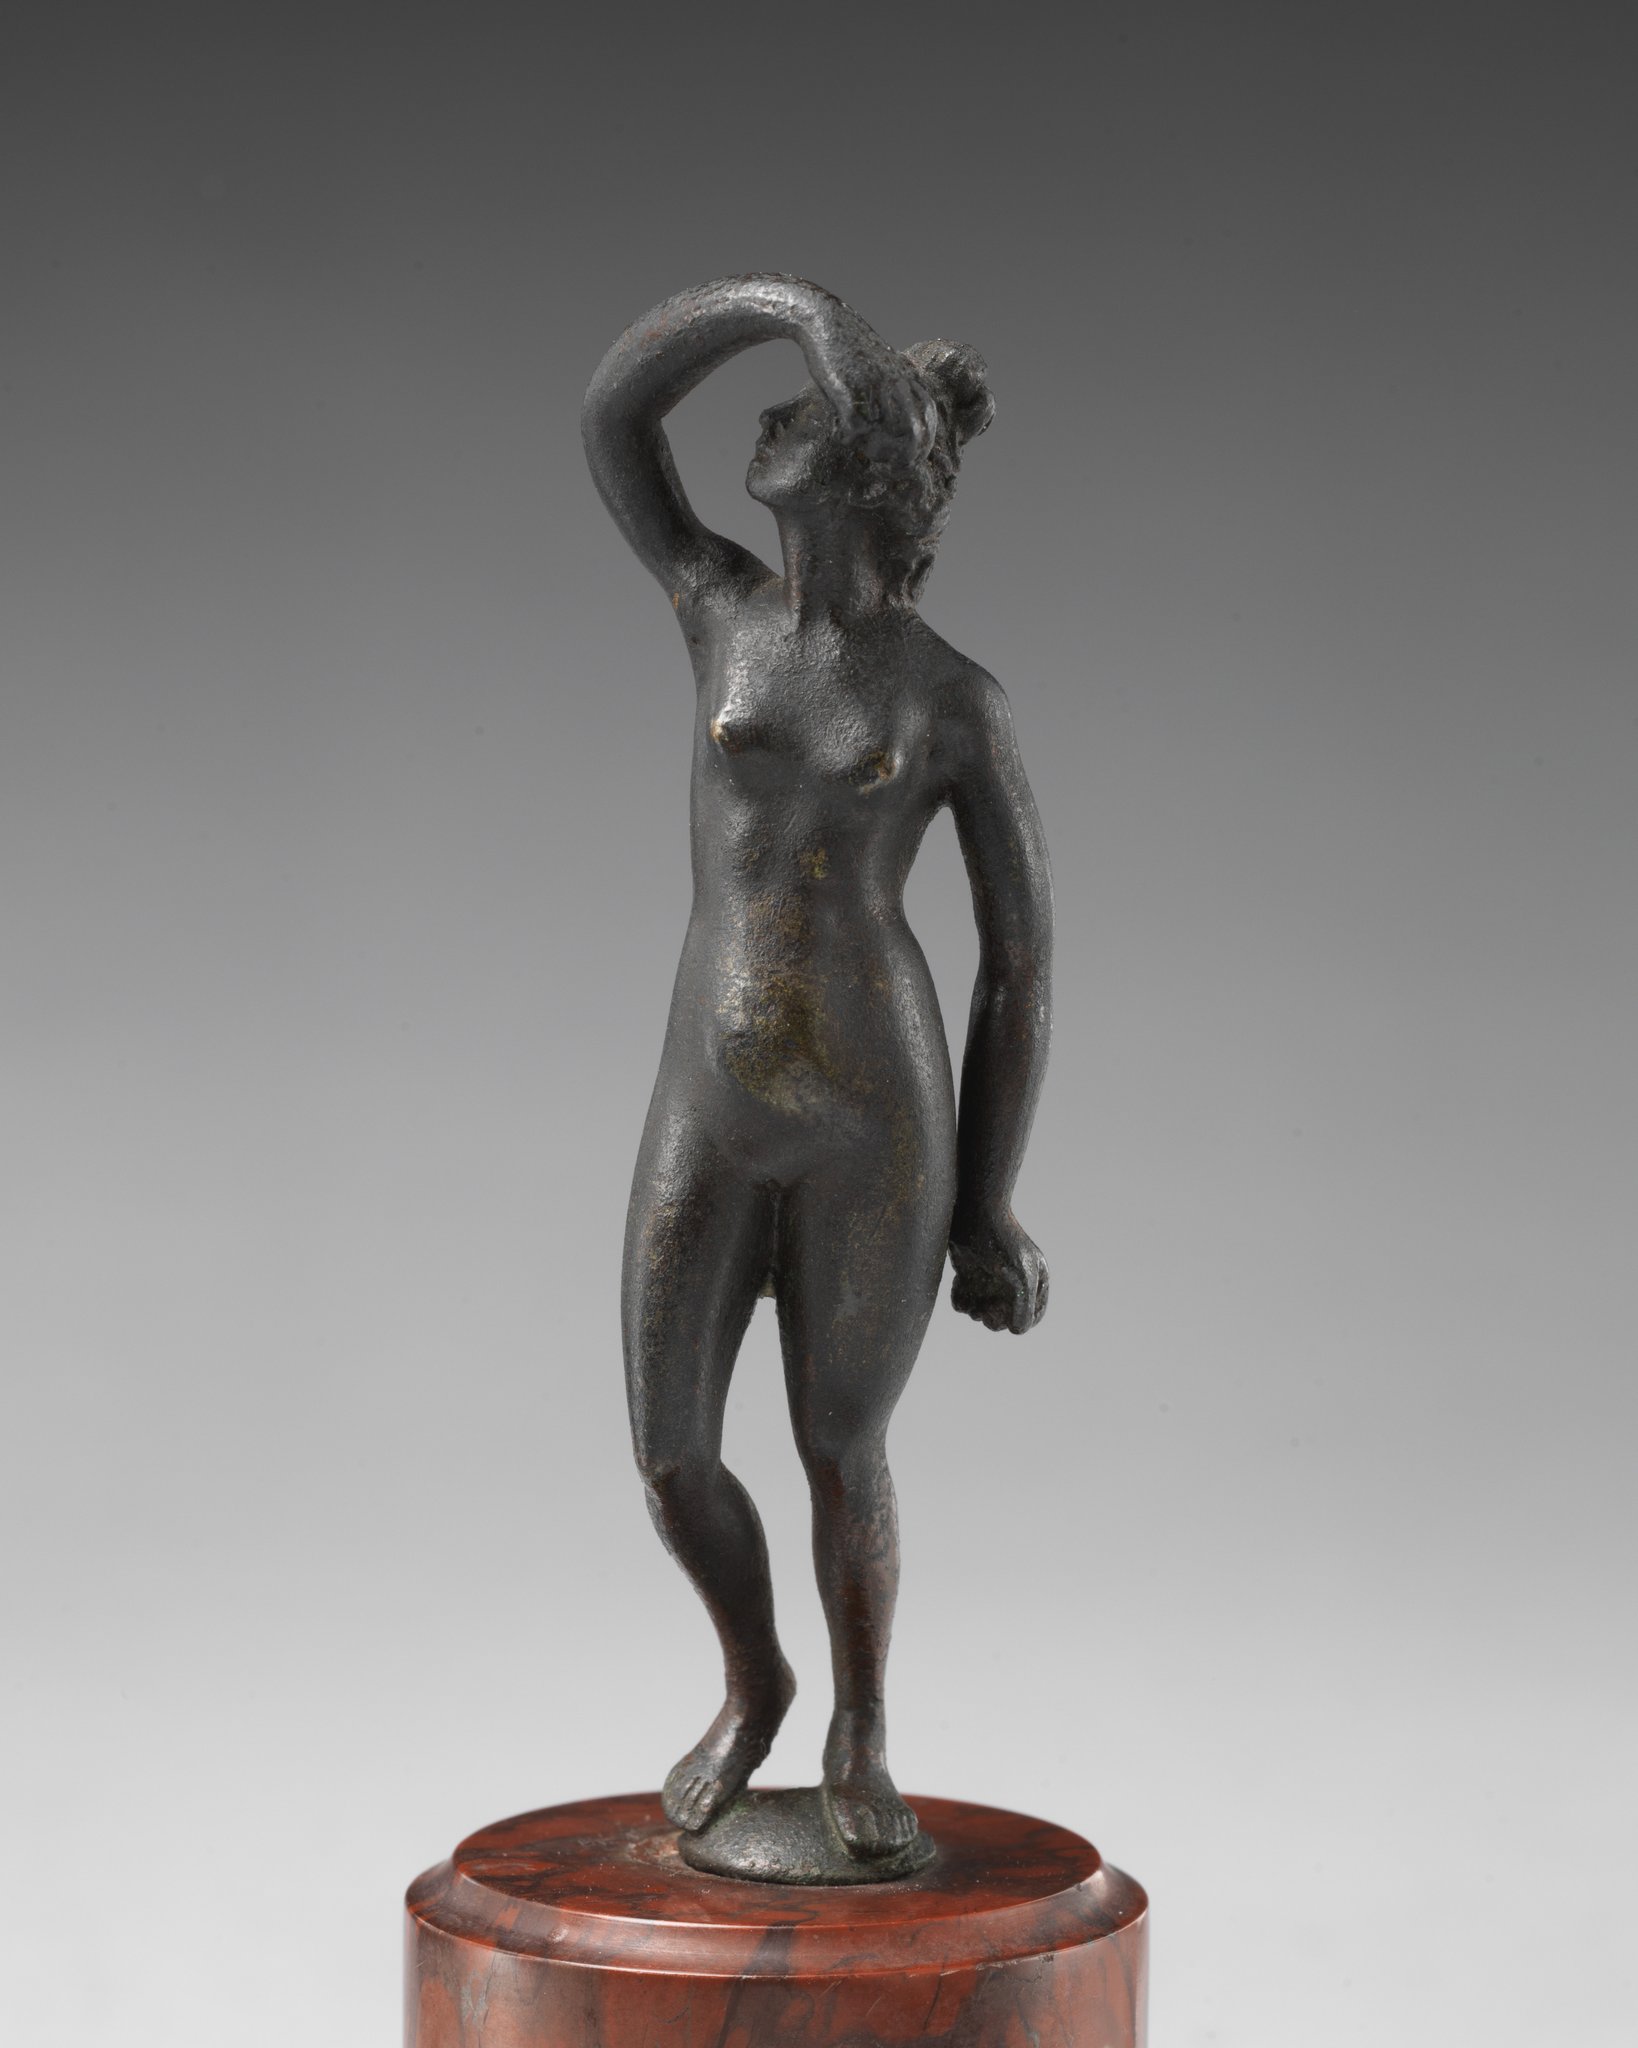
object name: statuette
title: Renaissance-style statuette of Venus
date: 1801-1900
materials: bronze, lacquer, patina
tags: venus